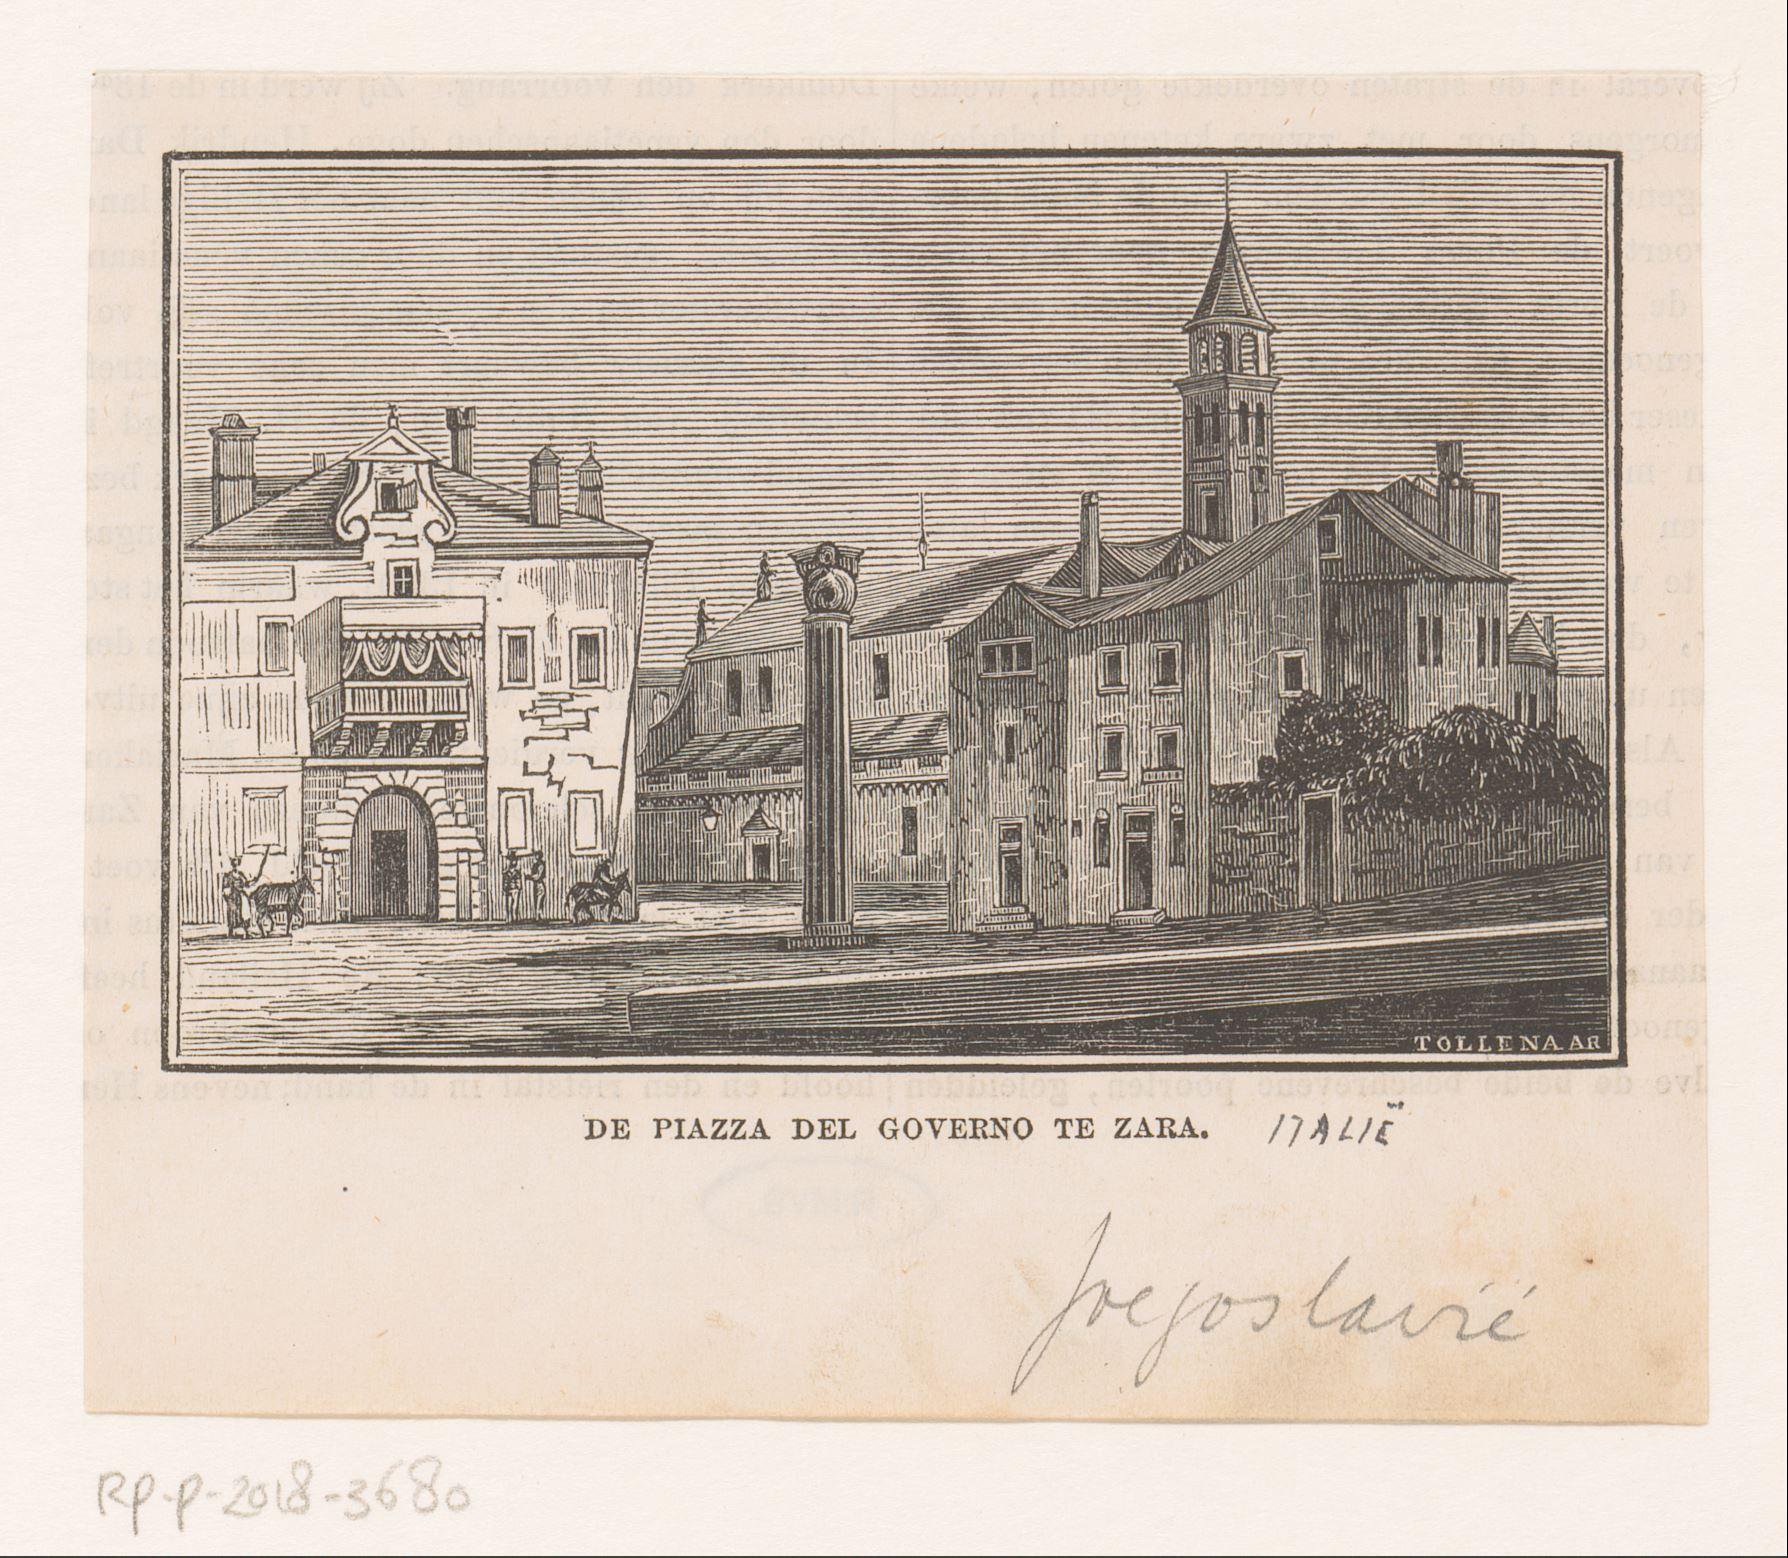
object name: print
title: De Piazza del Governo te Zara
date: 1847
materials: paper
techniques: letterpress printing, engraving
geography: amsterdam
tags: square, place, circus, etc., column, pillar ~ architecture, city-view in general; 'veduta'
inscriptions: collector's mark: Lugt 2228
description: Prent uit: Hollandsch Penning-Magazijn voor de Jeugd. Amsterdam: J.H. Laarman, 1847, p. 197.